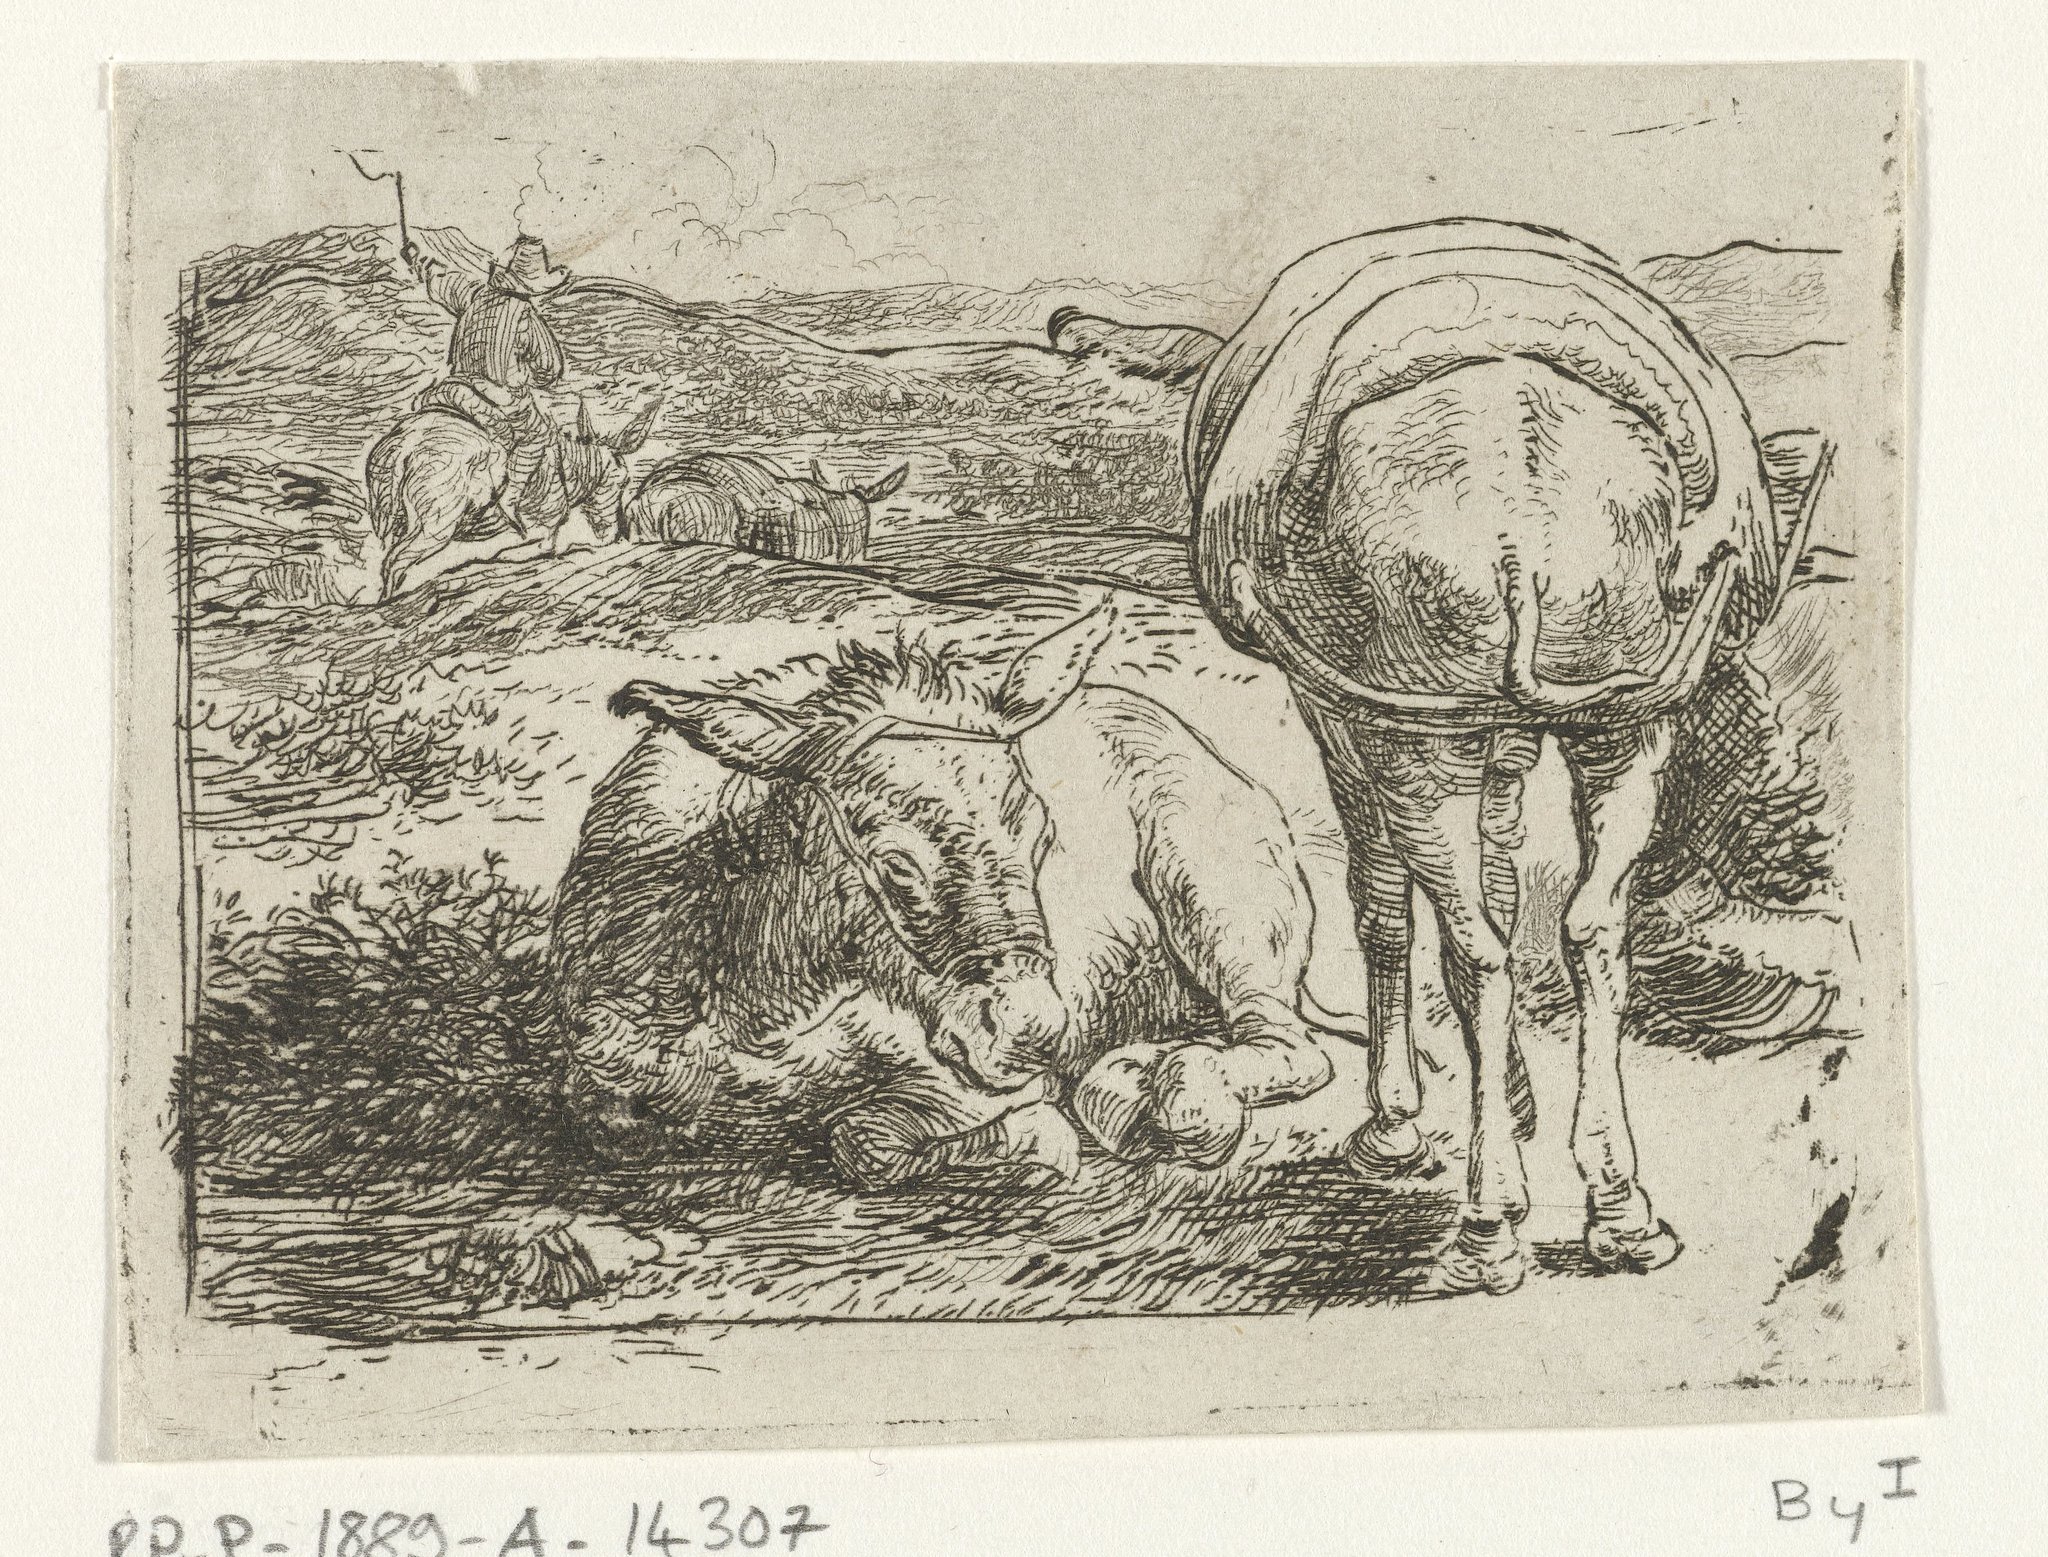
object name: print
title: Twee ezels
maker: jan van ossenbeeck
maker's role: print maker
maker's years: 1623-1674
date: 1647-1674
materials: paper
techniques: etching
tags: ass, donkey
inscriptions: collector's mark: Lugt 2228